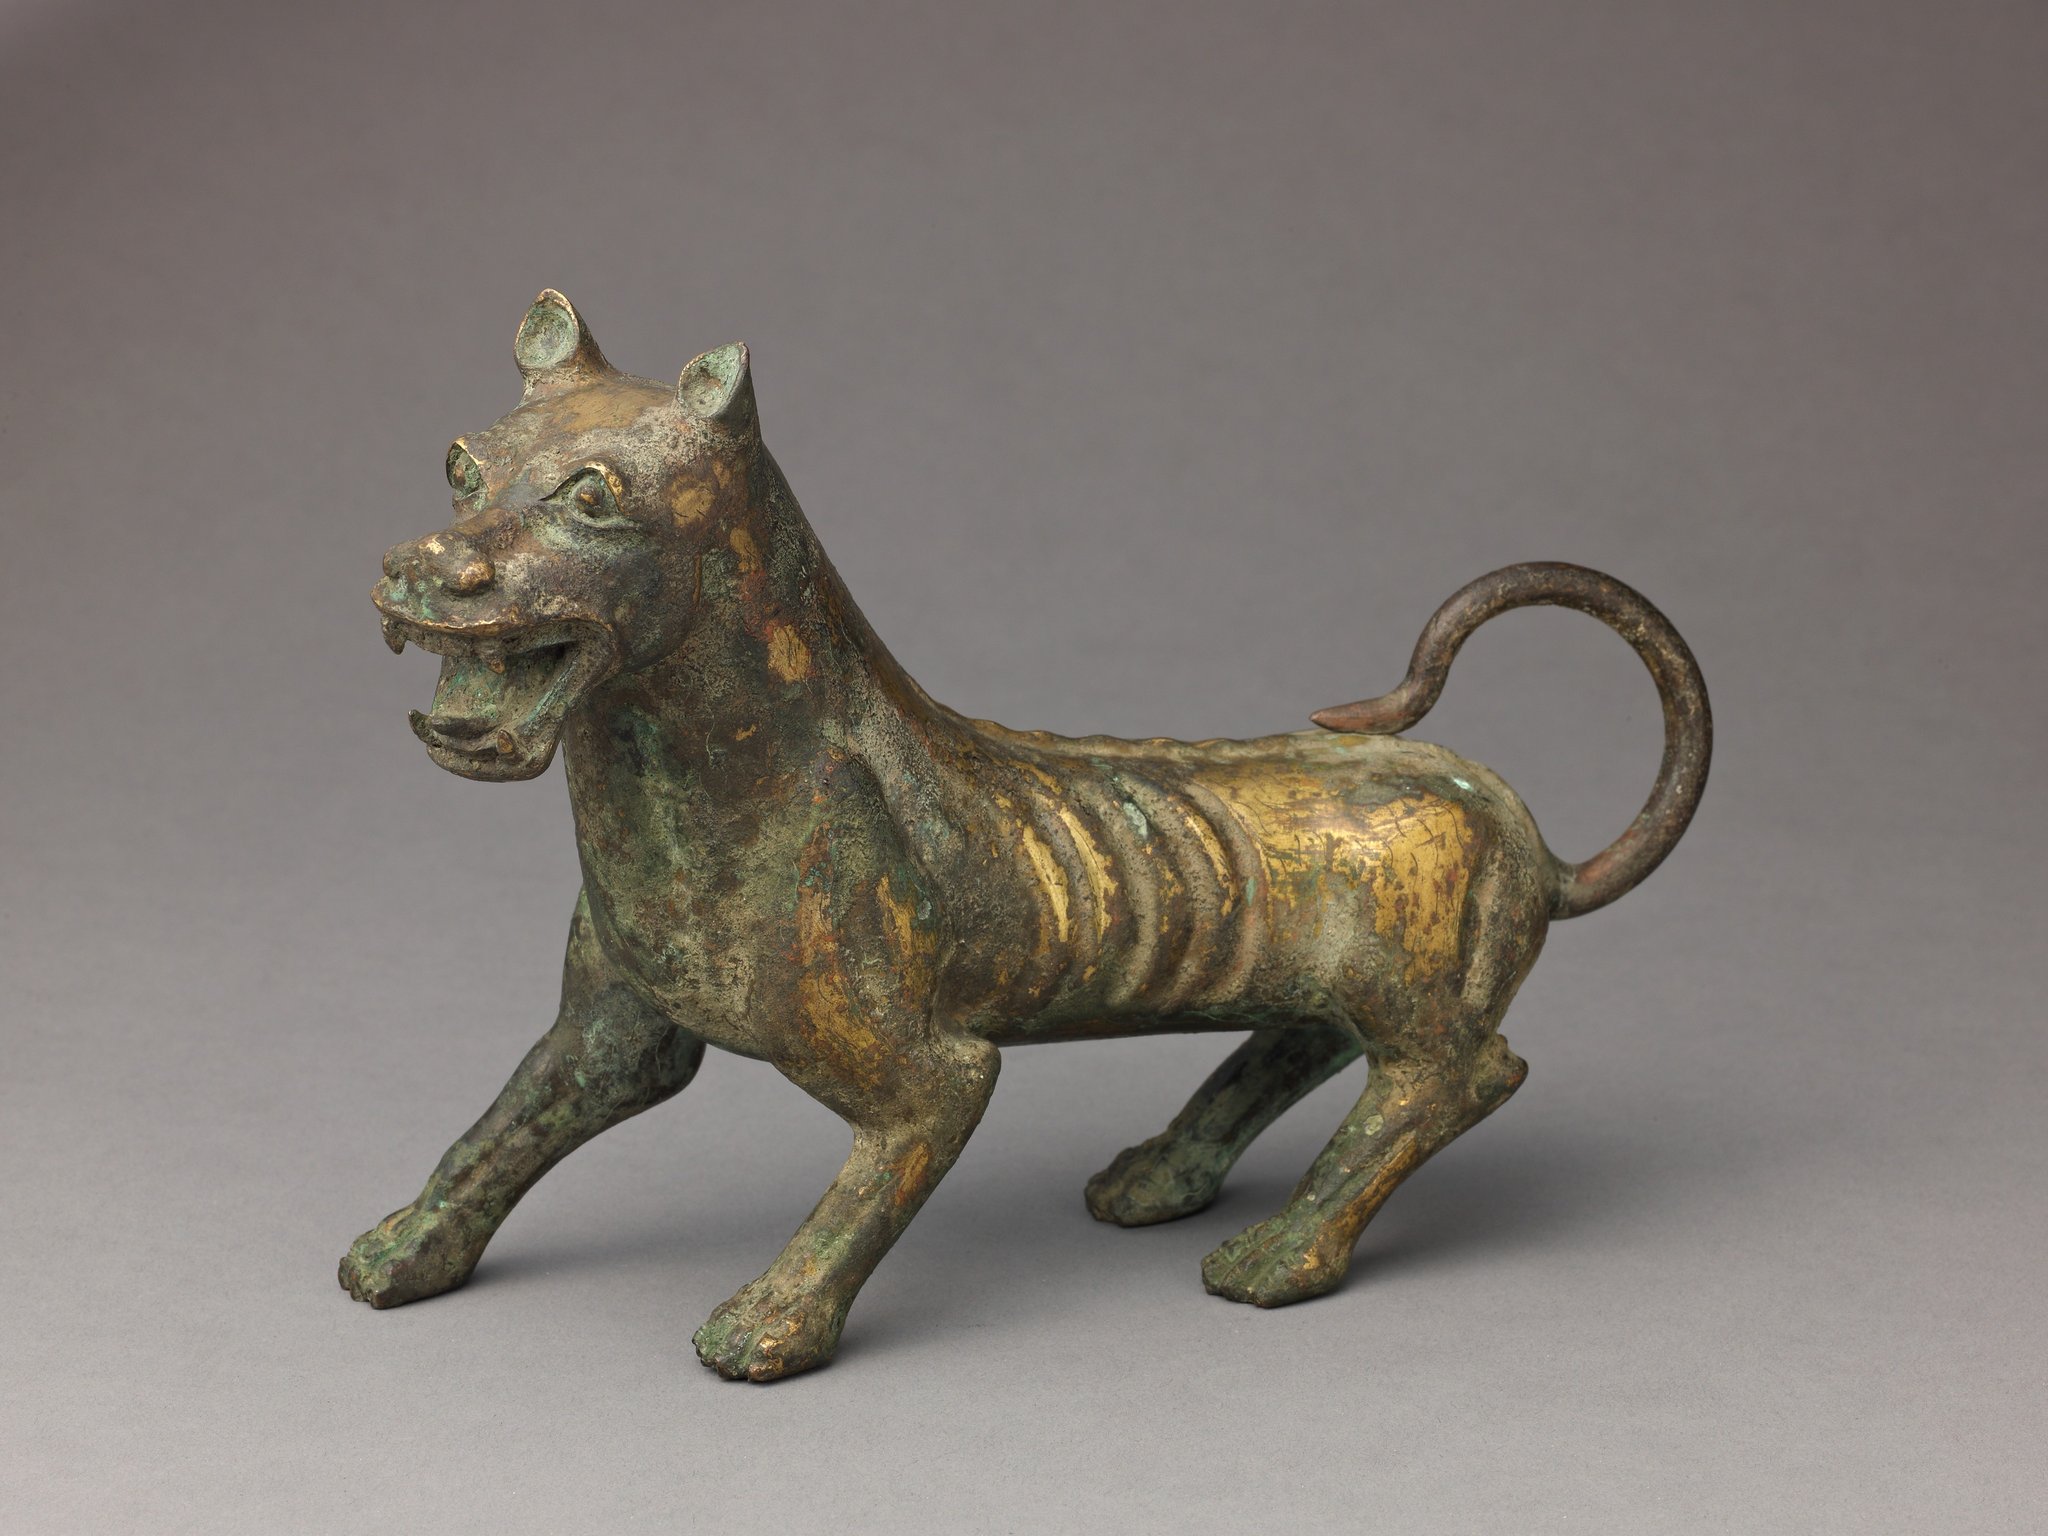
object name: sculpture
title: Dog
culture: chinese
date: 1867-1933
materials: copper alloy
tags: dogs